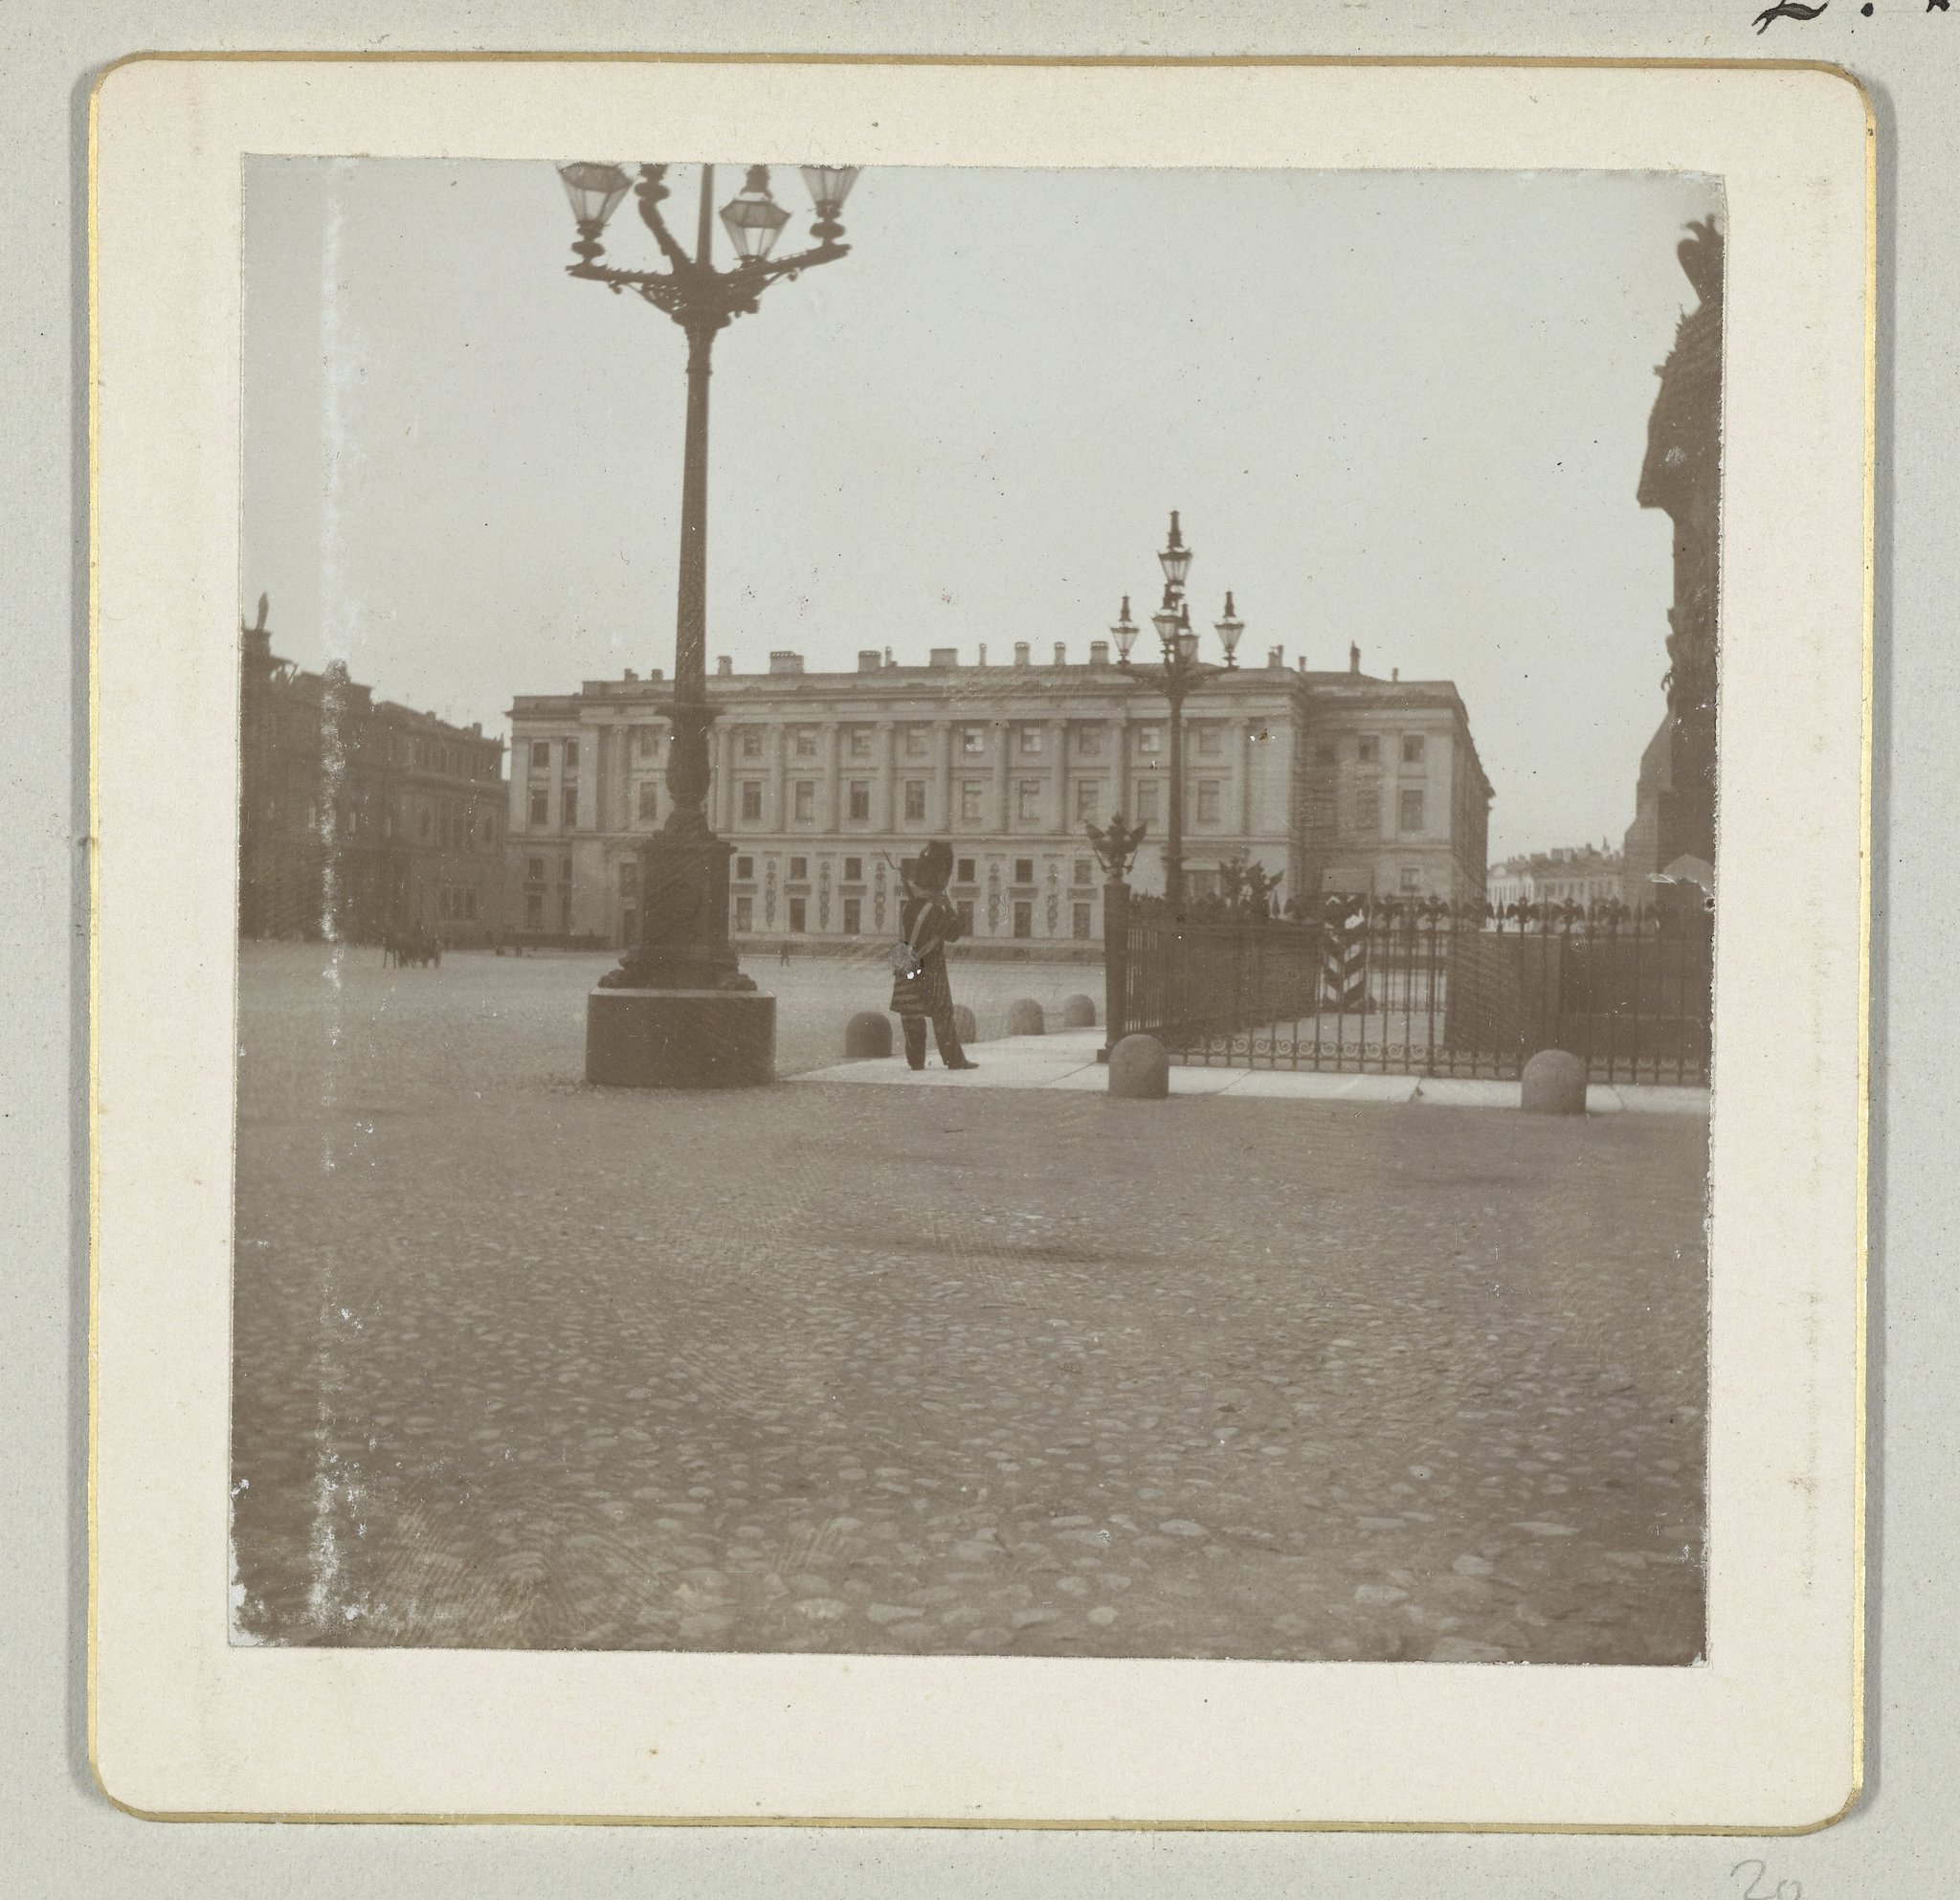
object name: photograph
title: St. Petersburg plein voor het Winterpaleis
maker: henry pauw van wieldrecht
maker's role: fotograaf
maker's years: 1863-1912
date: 1898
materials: paper, photographic support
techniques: albumen print